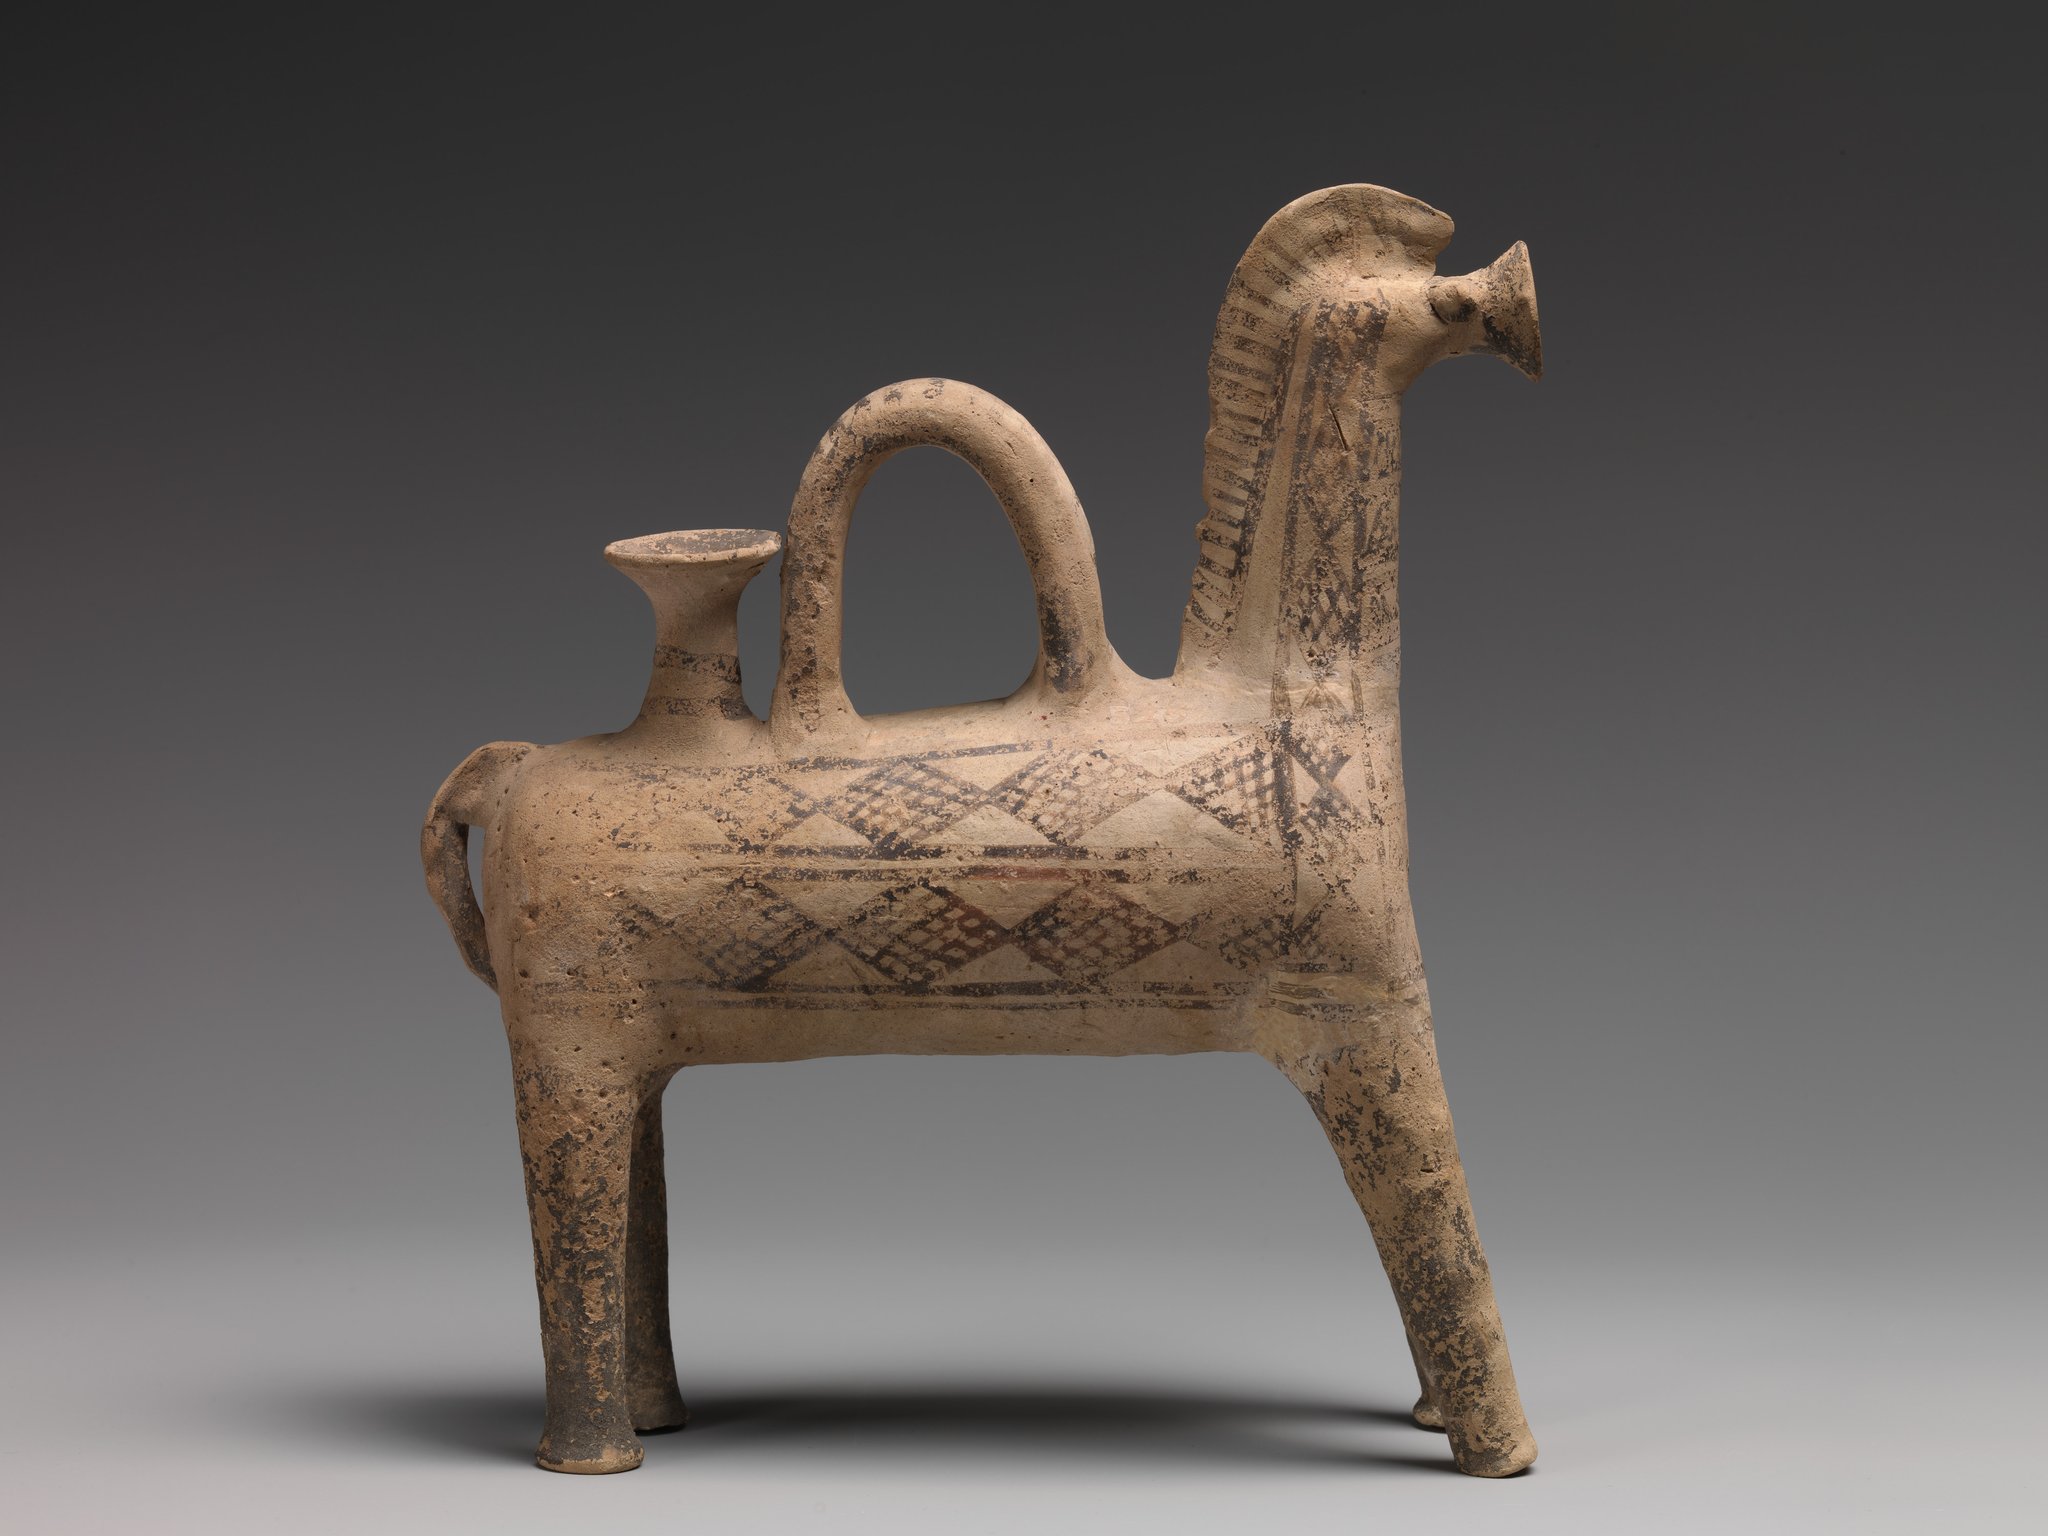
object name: rhyton in the form of a horse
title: Terracotta rhyton (libation vessel) in the form of a horse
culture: cypriot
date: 1200-1050 BCE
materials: terracotta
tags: horses